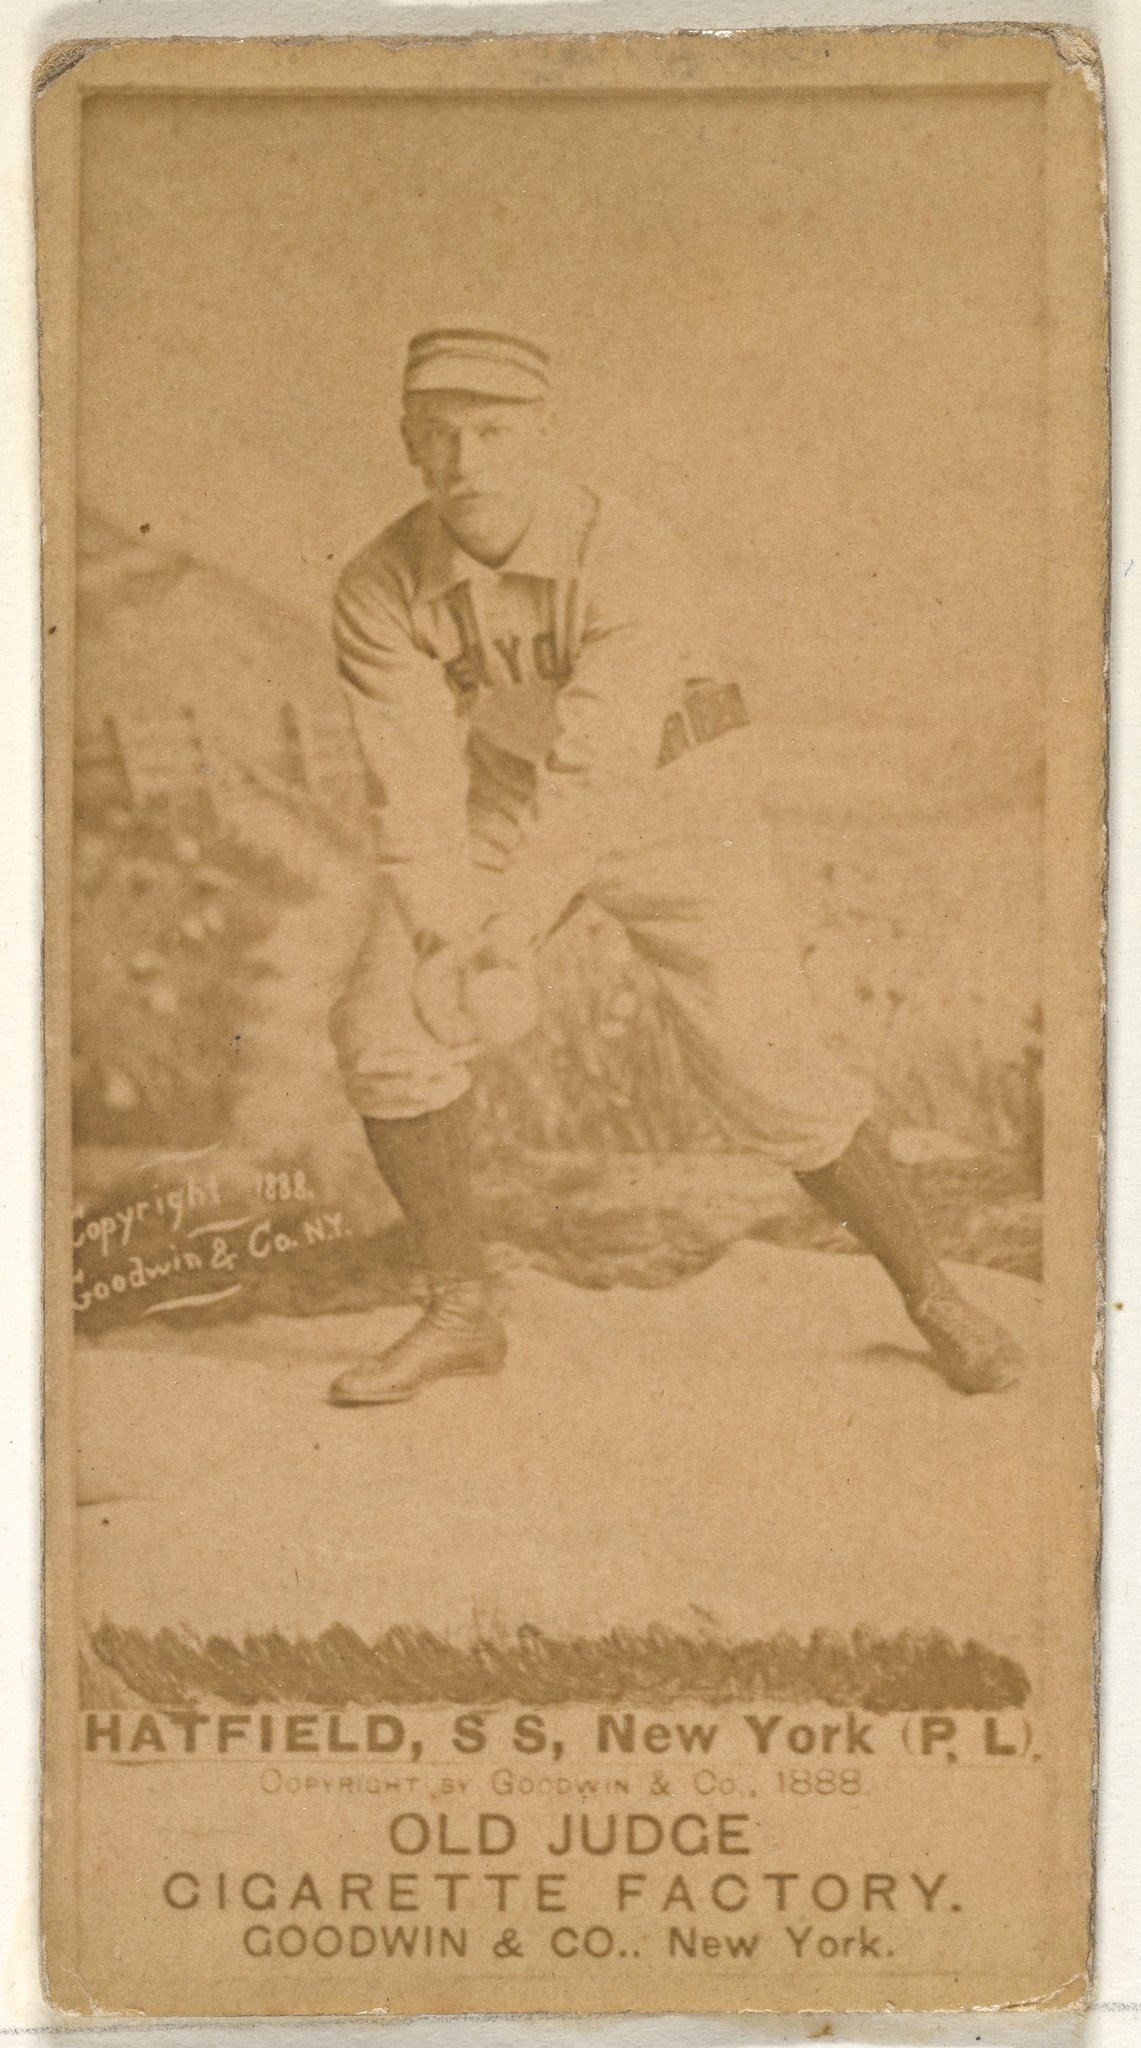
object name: baseball card, photograph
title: Gil Hatfield, Shortstop, New York, from the Old Judge series (N172) for Old Judge Cigarettes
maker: goodwin & company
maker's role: publisher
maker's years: 1850-1950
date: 1888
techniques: albumen silver print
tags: men,portraits,baseball,athletes